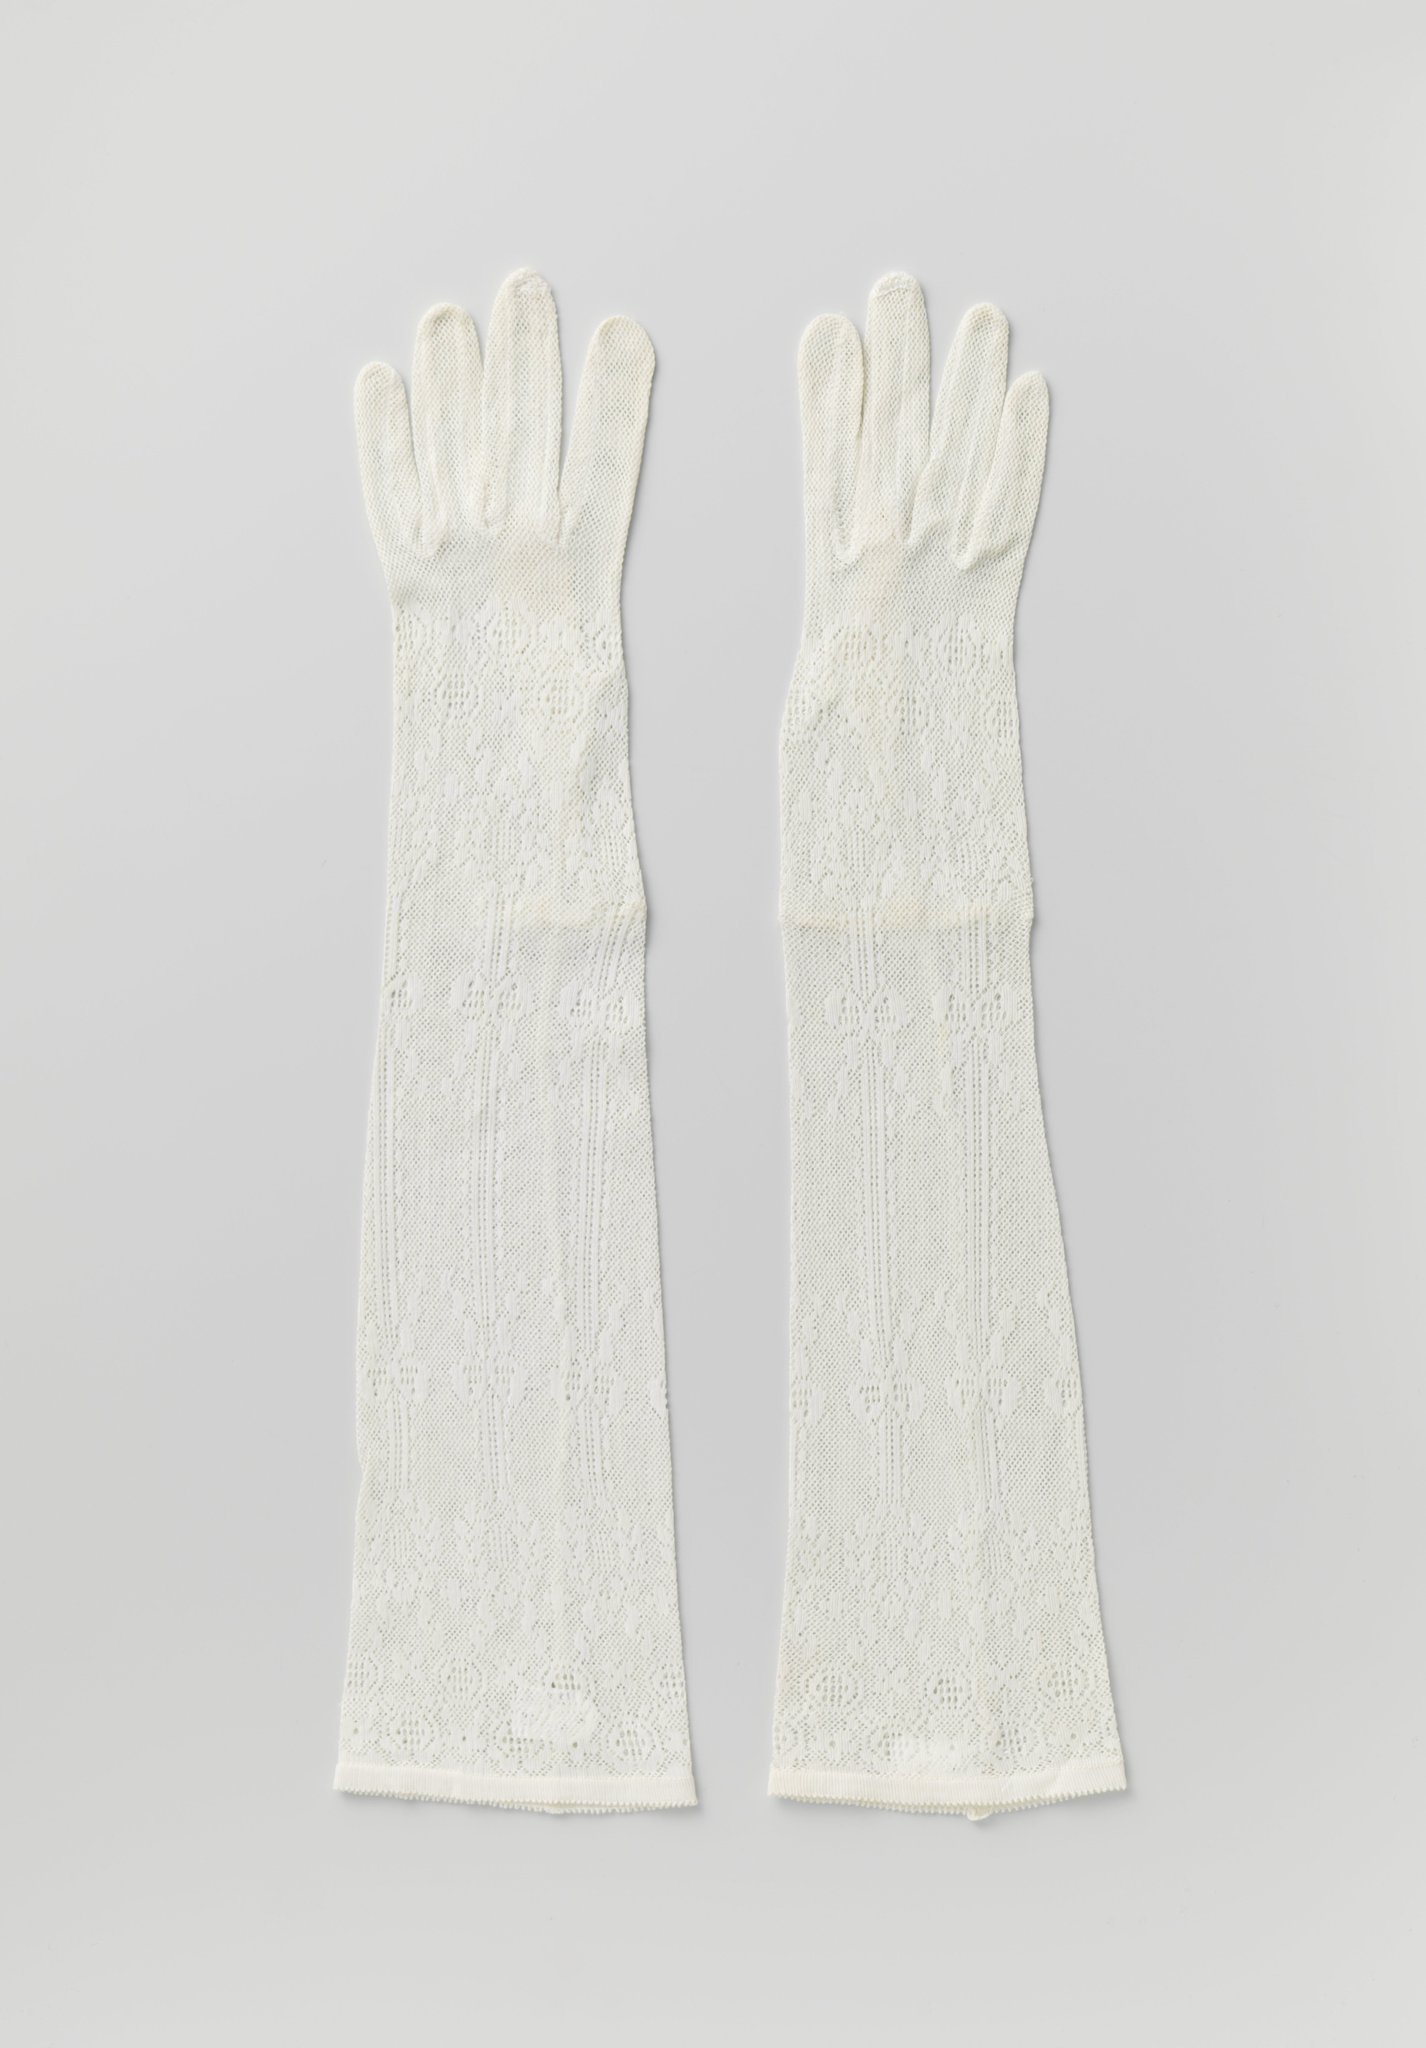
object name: glove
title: Handschoen van wit machinaal breiwerk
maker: Anonymous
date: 1925-1935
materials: cotton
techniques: knitting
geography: western europe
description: Paar lange dameshandschoenen van uit machinaal kantwerk. Bij de pols een elastiekje. Patroon. Bovendien de vingers van fijne mazen staan lange pijlen versierd met twee knopen en overgaand en beide einden in een dwarsrand met rasterwerk en rondjes.